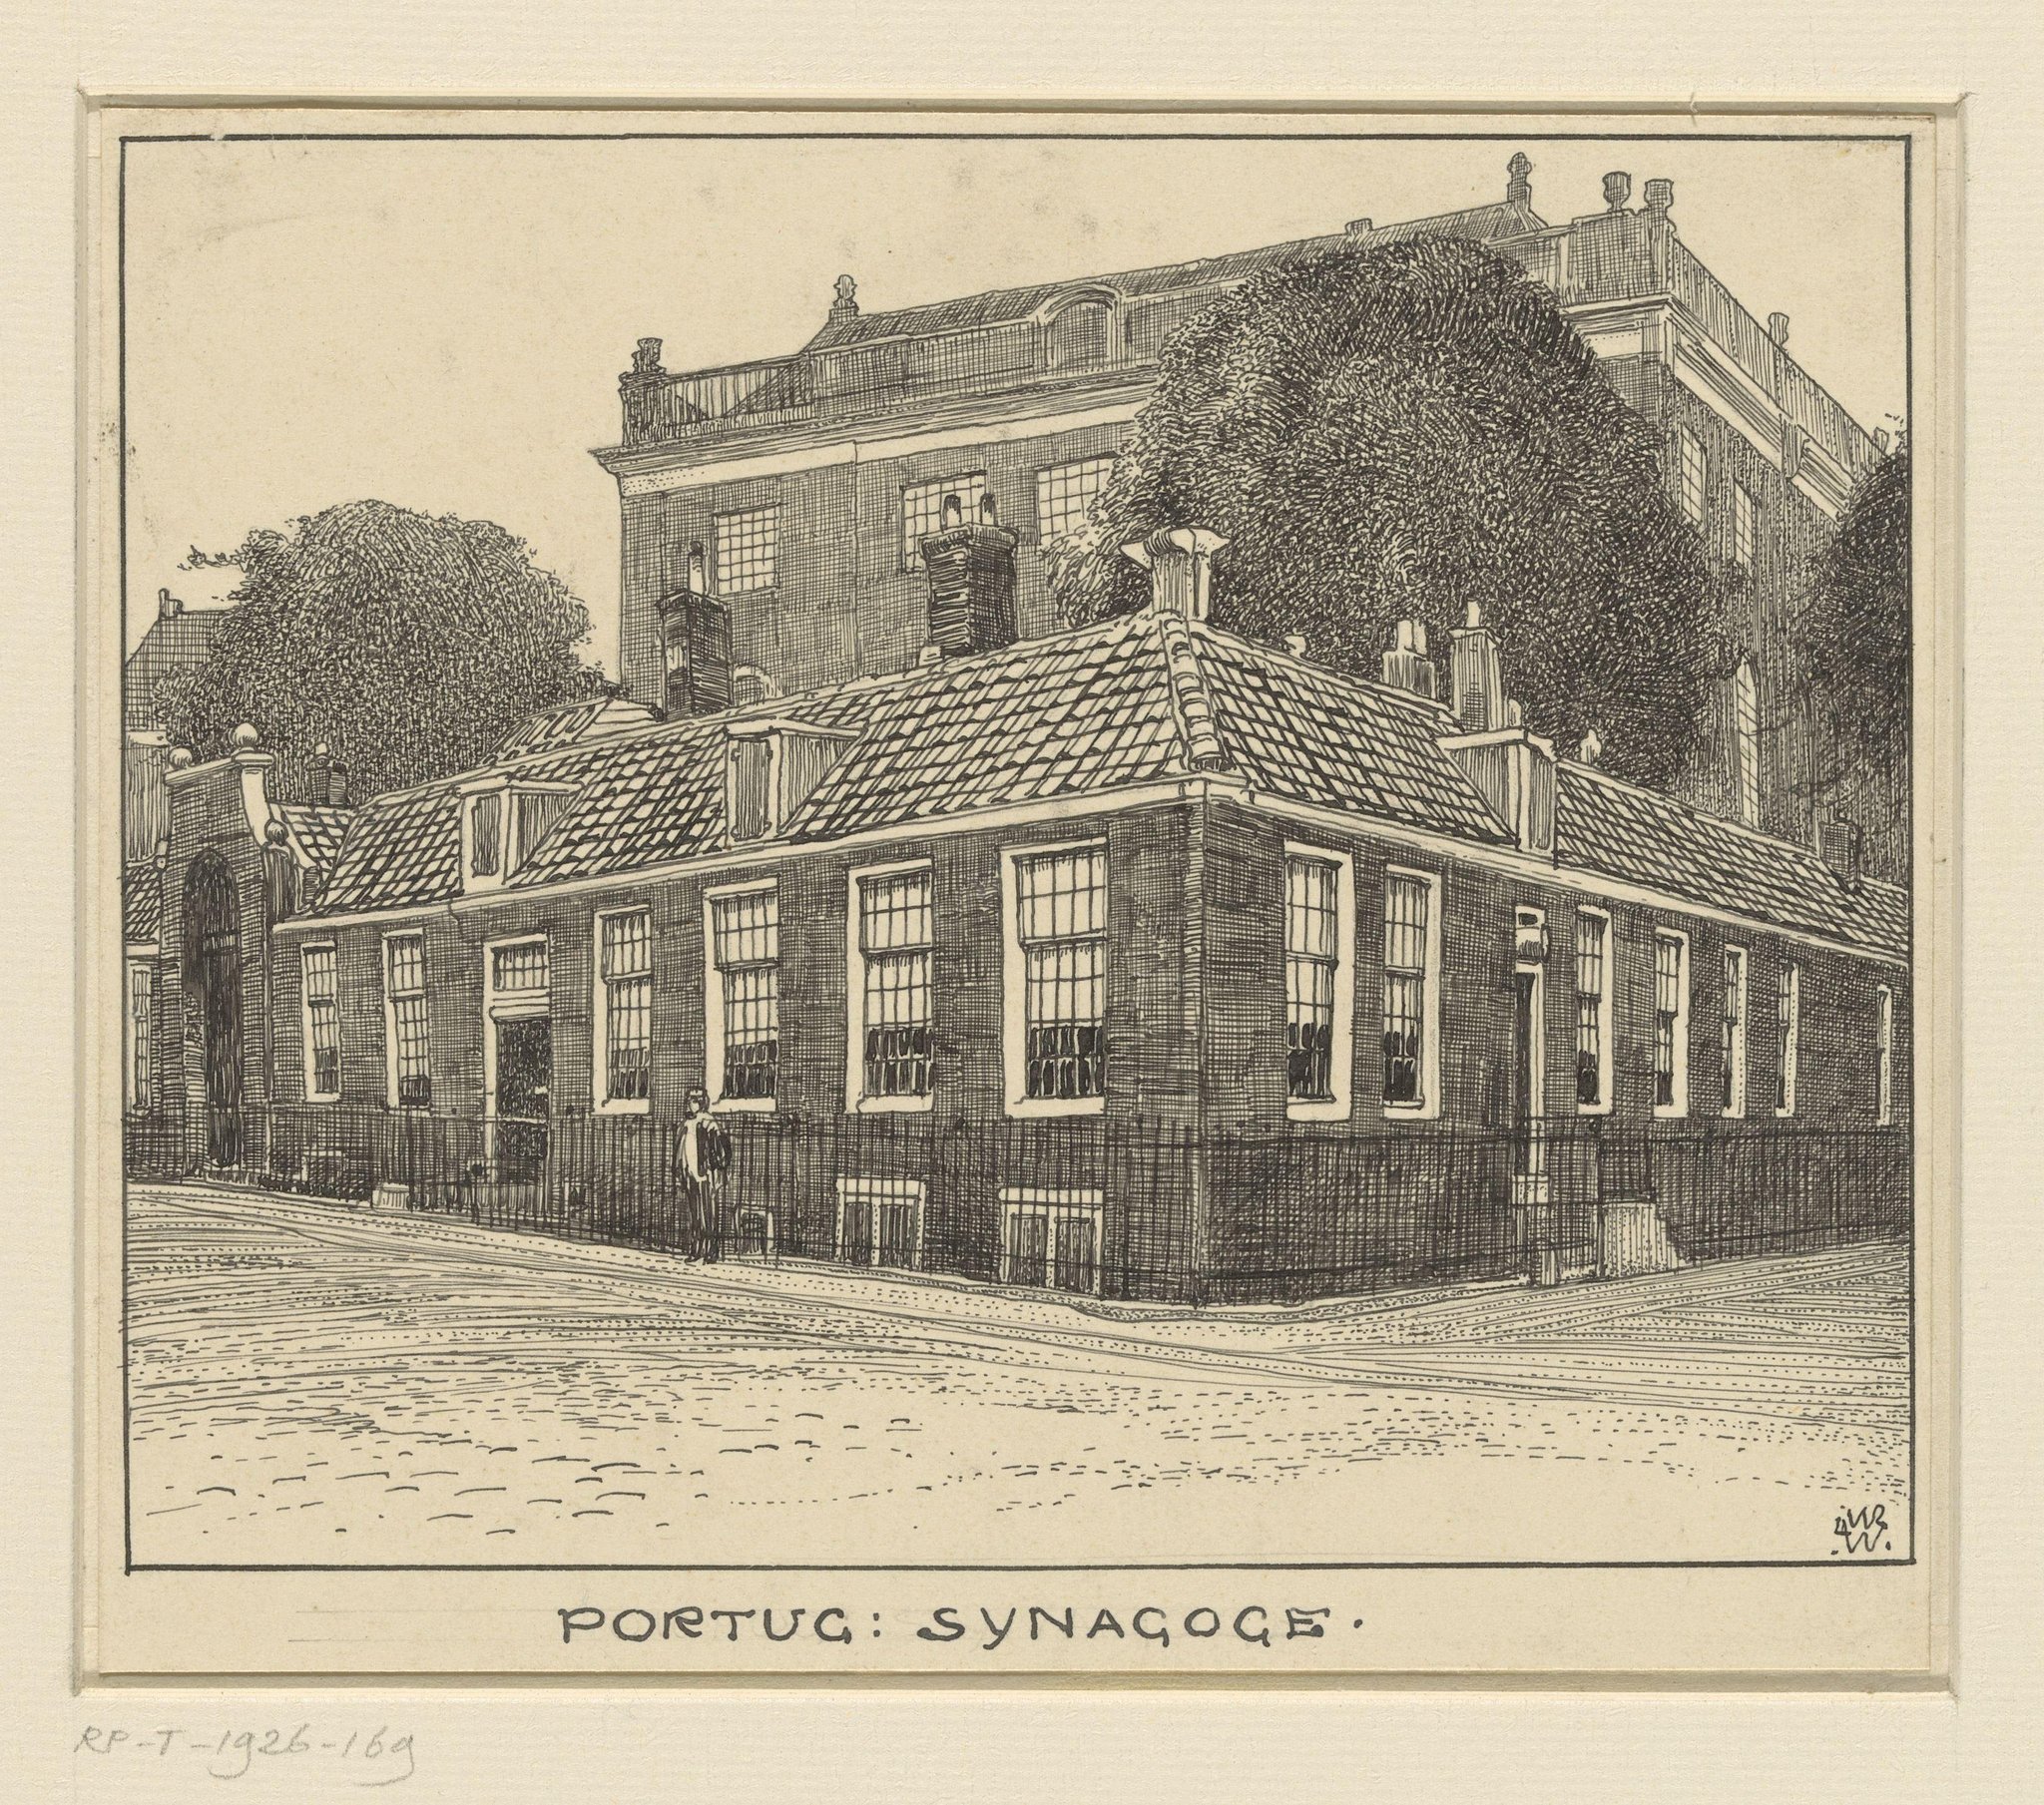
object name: drawing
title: De Portugese Synagoge te Amsterdam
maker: willem wenckebach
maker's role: designer, draughtsman, painter, print maker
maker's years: 1860-1937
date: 1870-1926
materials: ink, paper, pencil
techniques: pen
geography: amsterdam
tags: city-view in general; 'veduta', the synagogue (as building and place of worship ~ jewish religion)